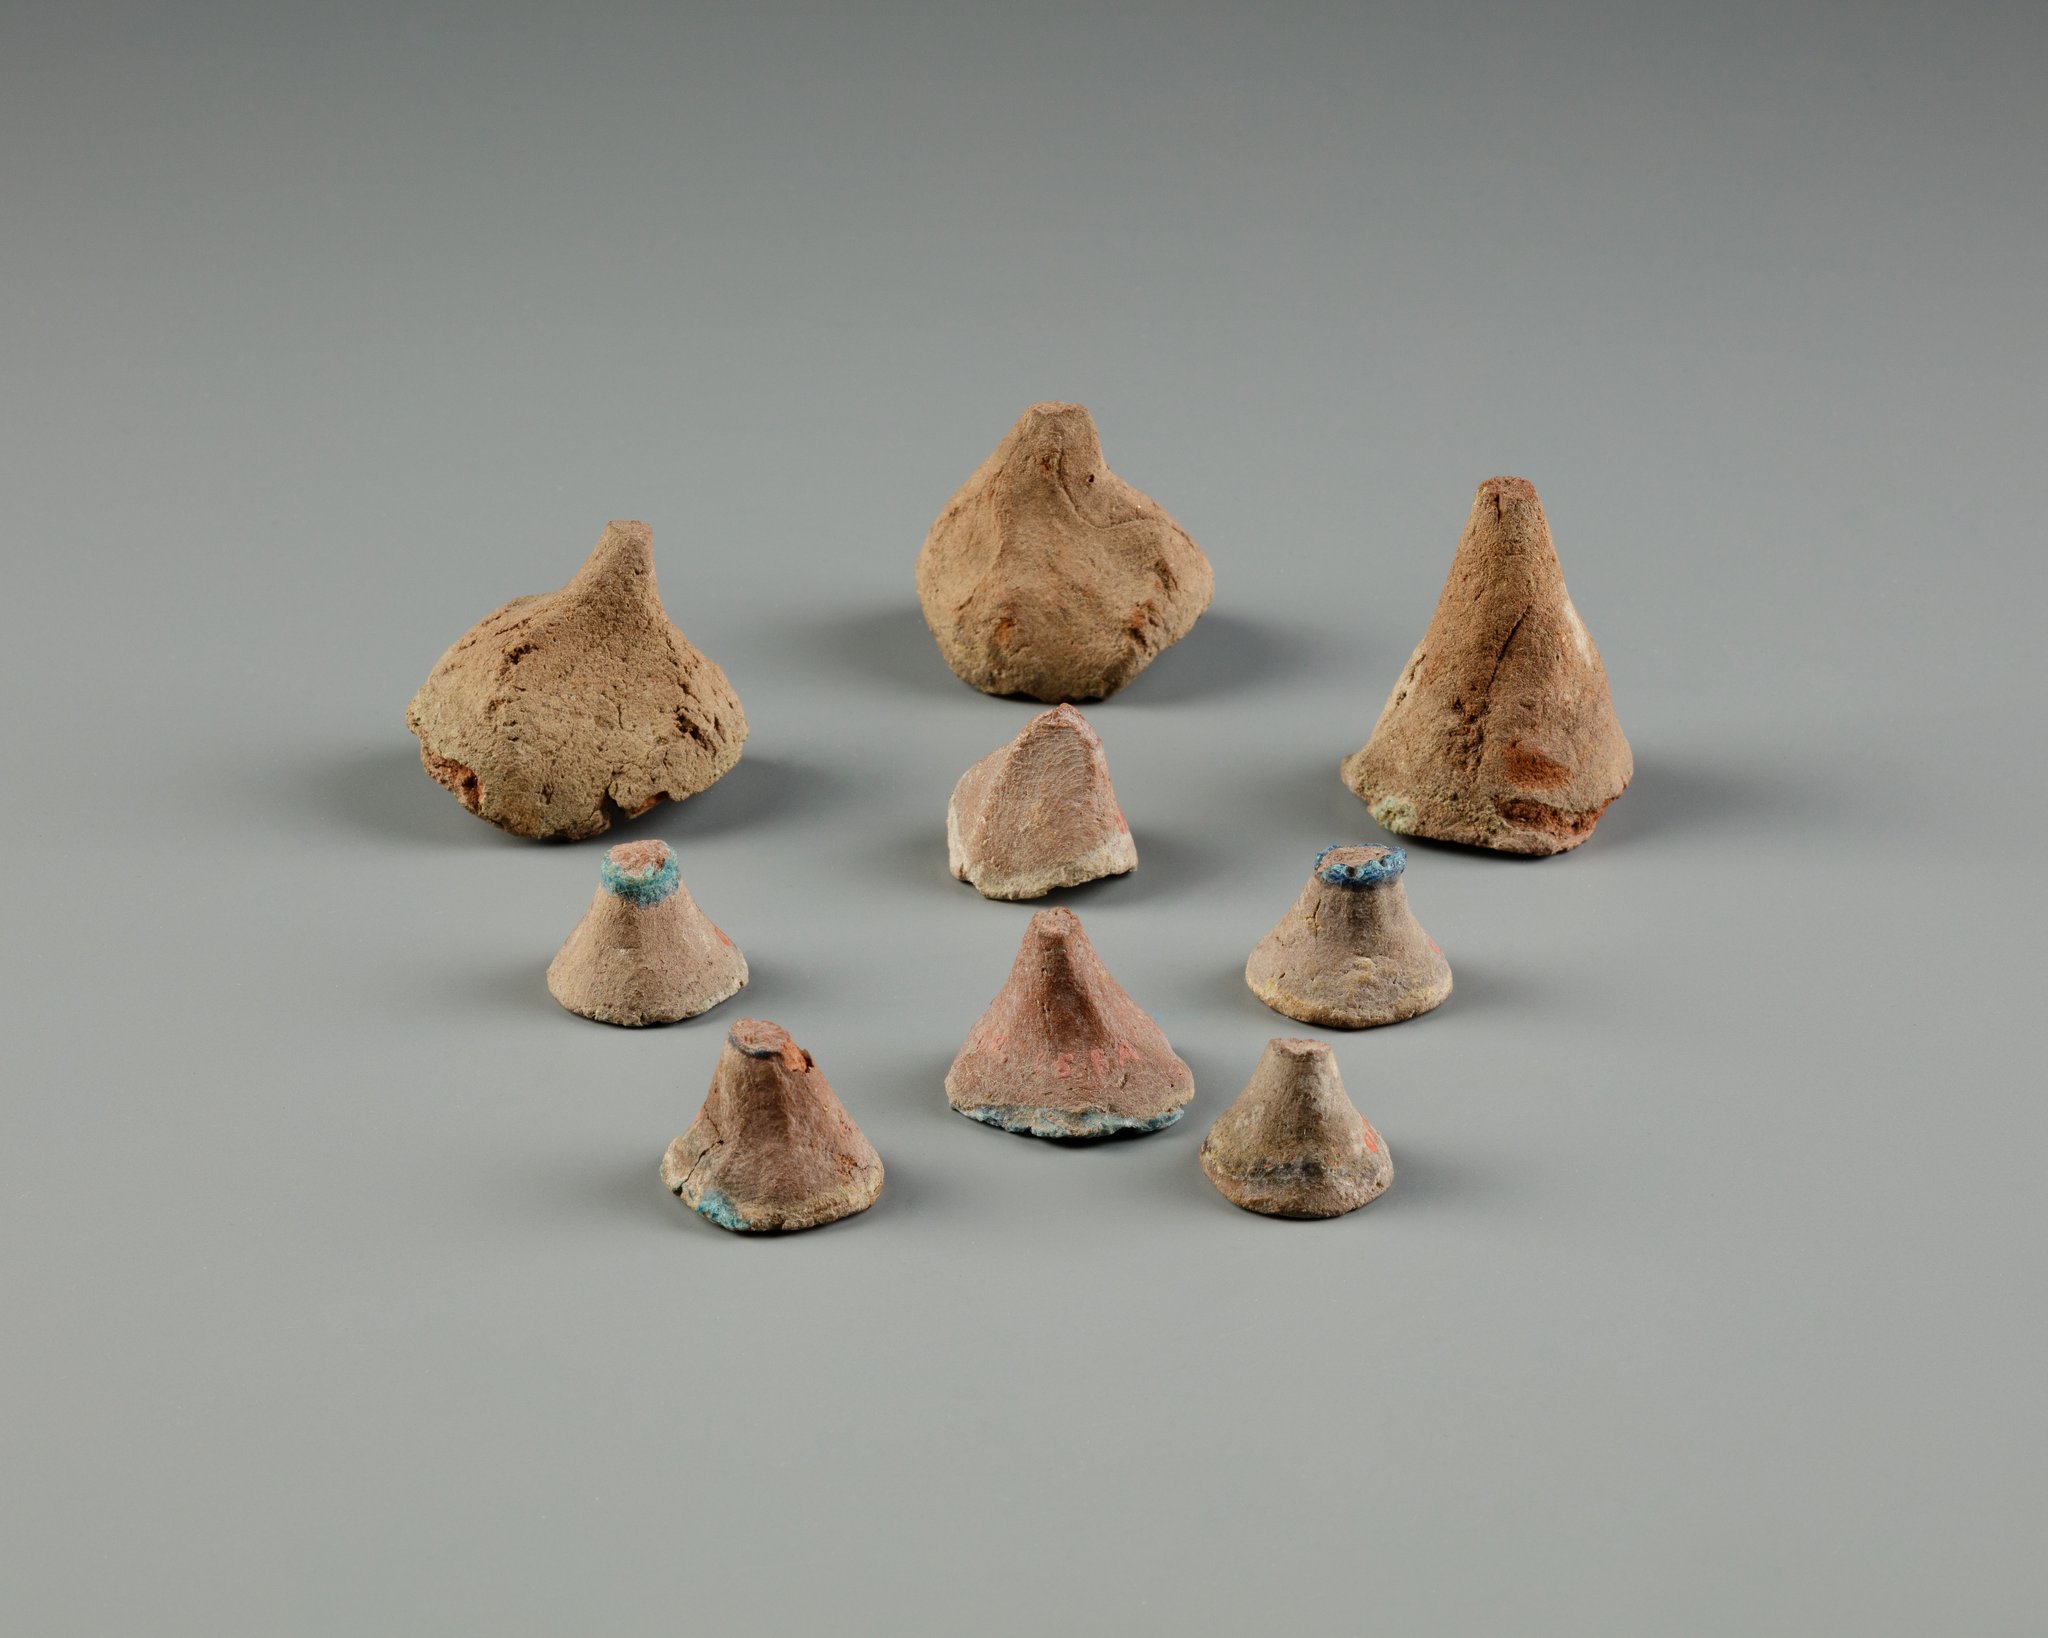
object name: support, faience production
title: Kiln supports for faience production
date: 100-1 BCE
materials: faience, pottery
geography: egypt